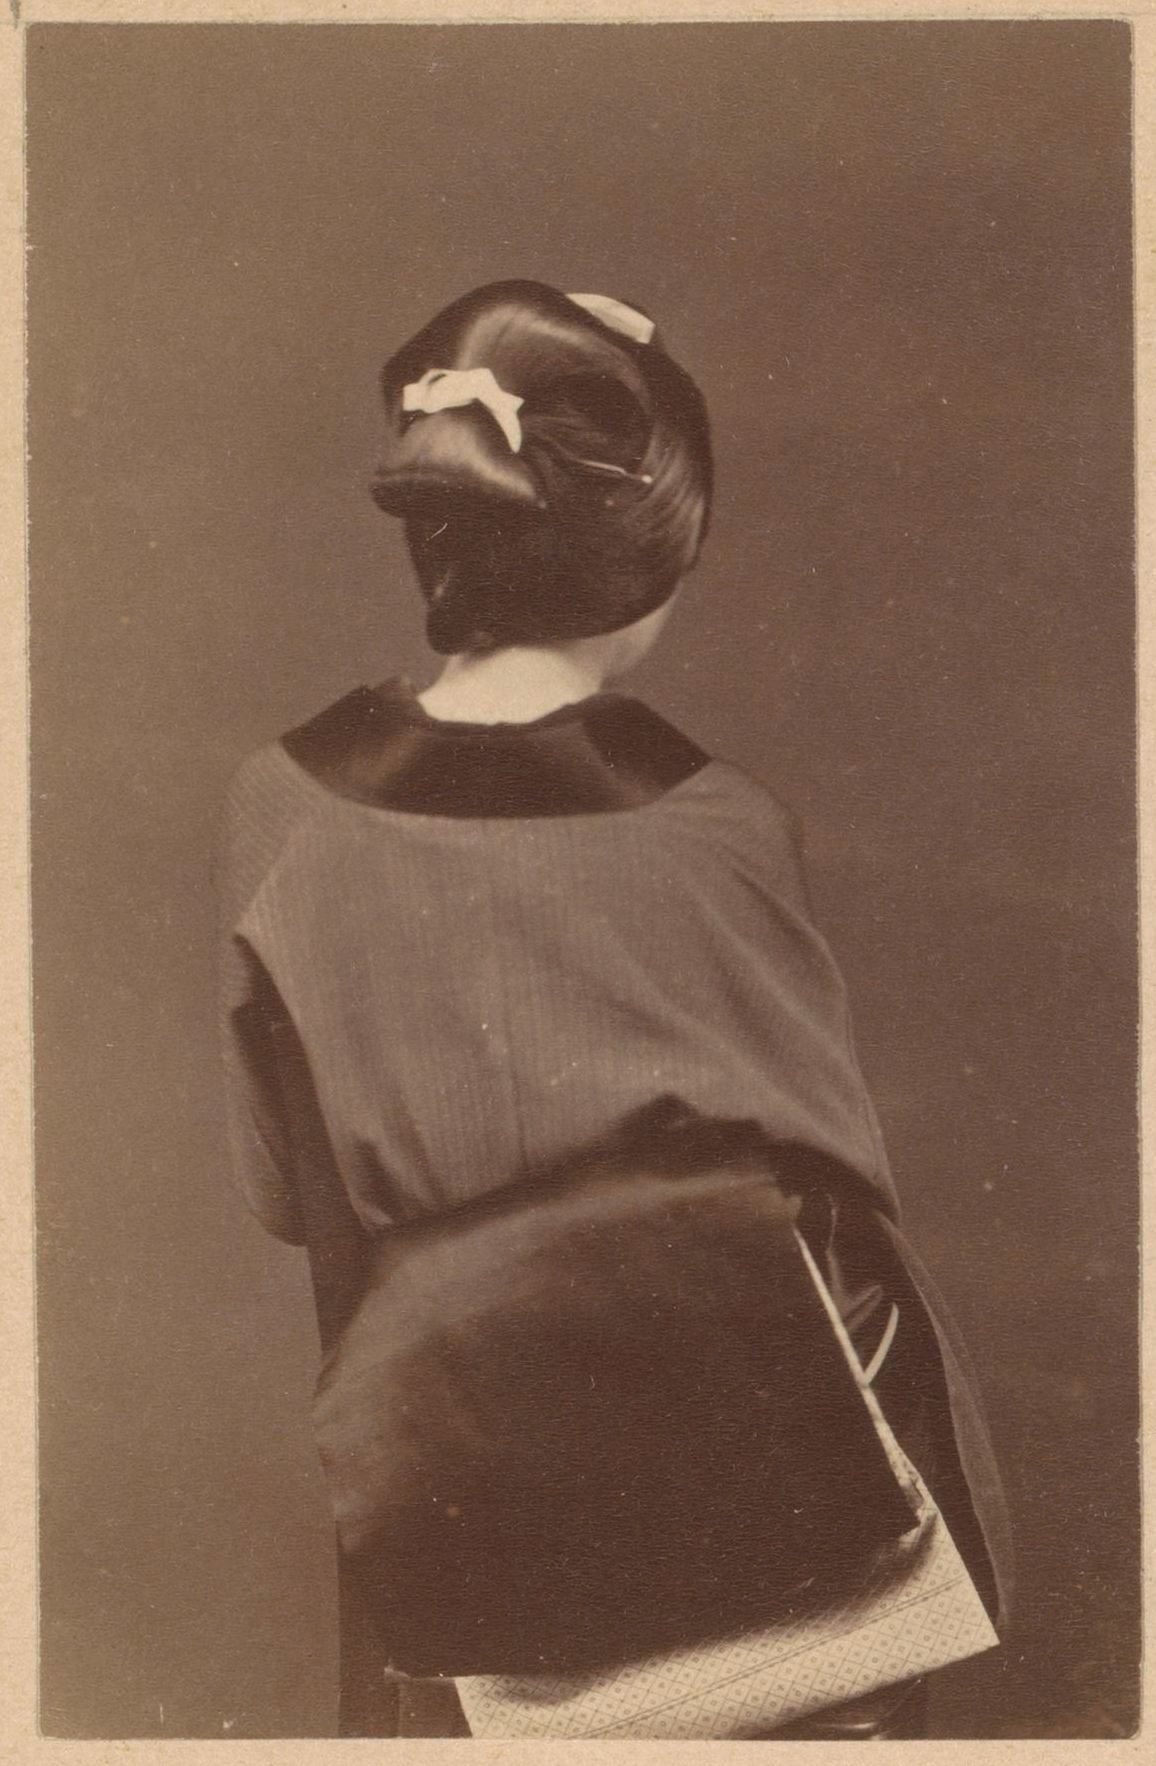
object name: photograph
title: Japan 1885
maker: Anonymous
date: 1885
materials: cardboard, paper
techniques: albumen print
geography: japan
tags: adult woman, japan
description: Onderdeel van een blad met tien portretten van Japanse vrouwen.